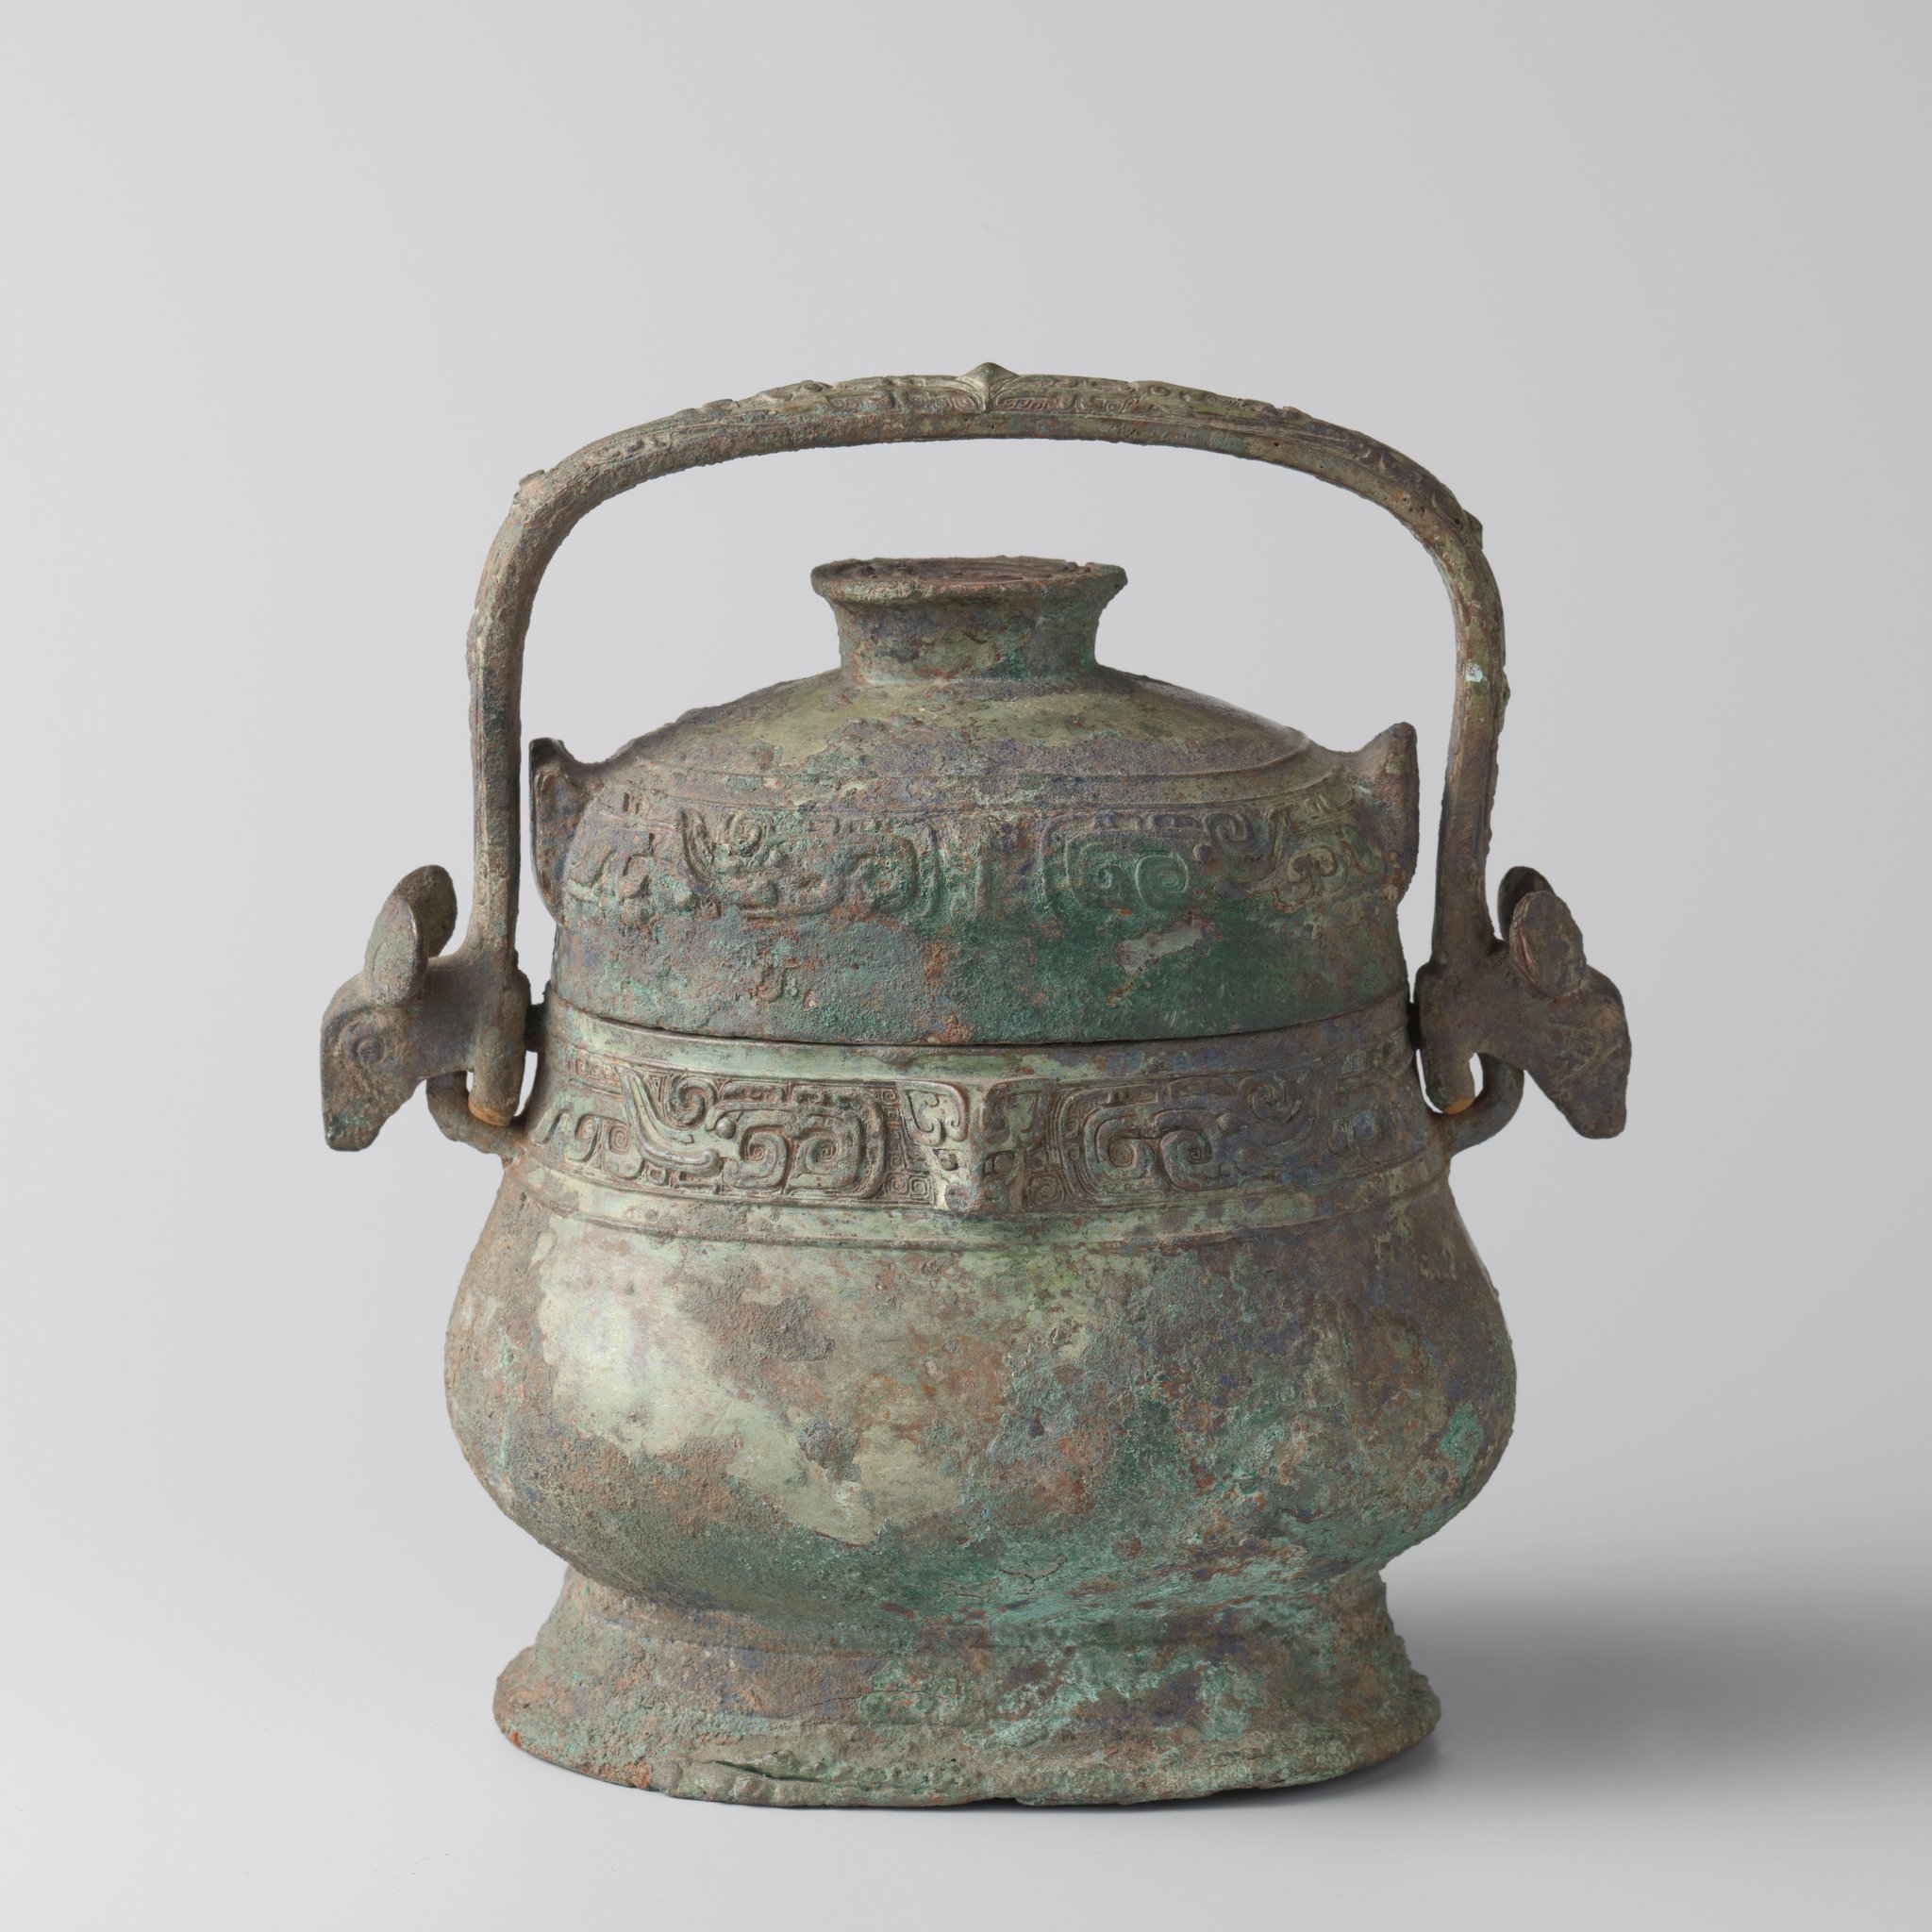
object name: you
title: Ritual wine vessel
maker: Anonymous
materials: bronze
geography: china